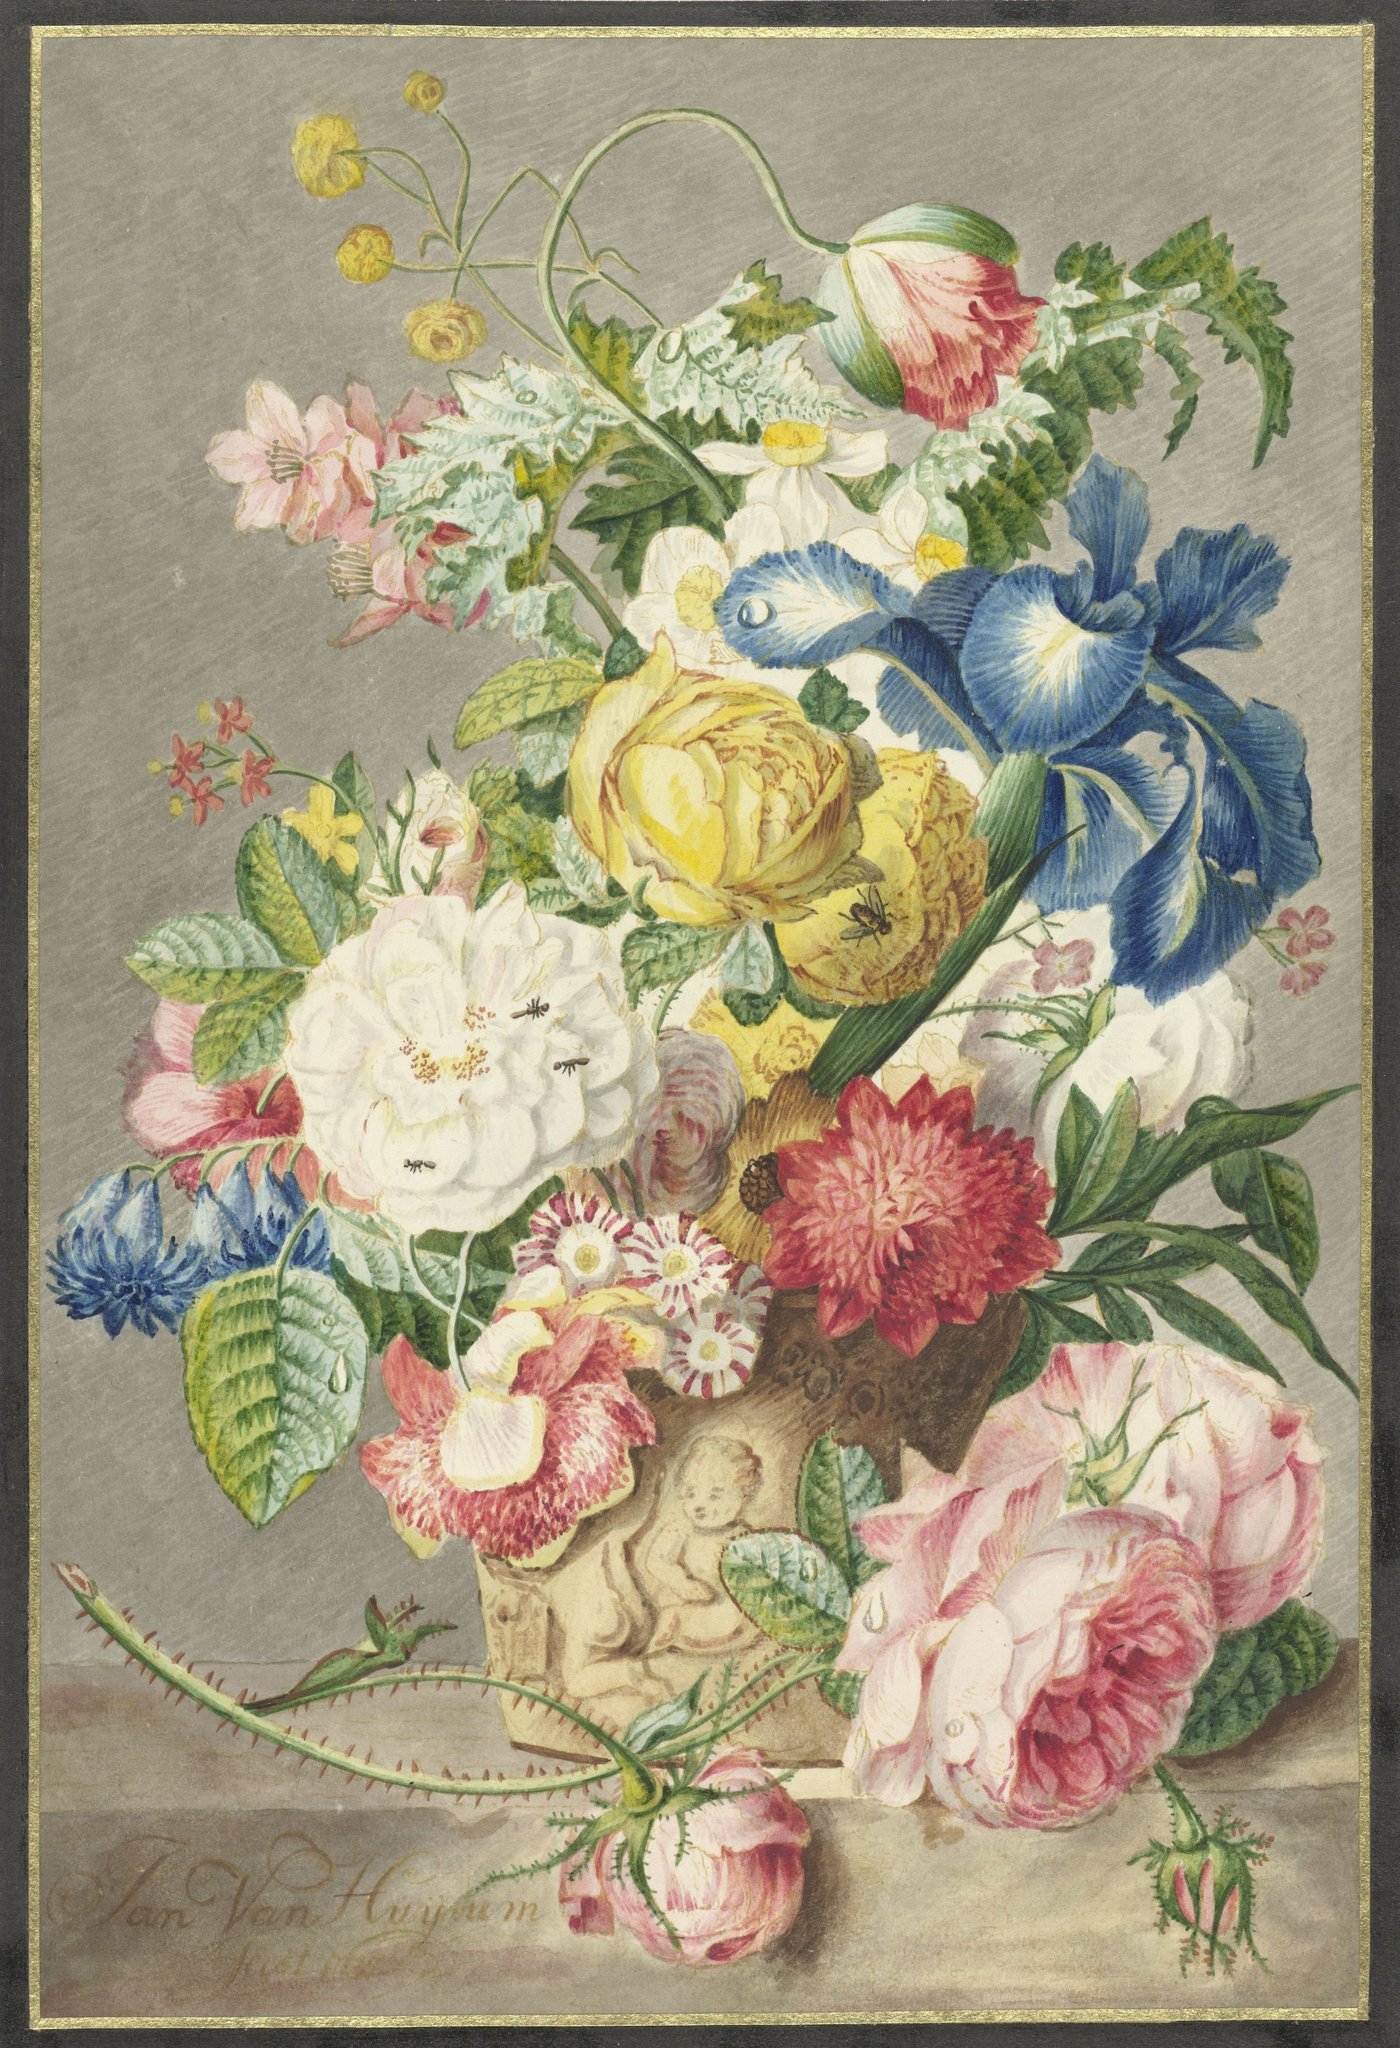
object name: print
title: Bouquet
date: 1778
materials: paper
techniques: etching, hand coloring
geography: amsterdam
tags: flowers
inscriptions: collector's mark: Lugt 2725, collector's mark: Lugt 12